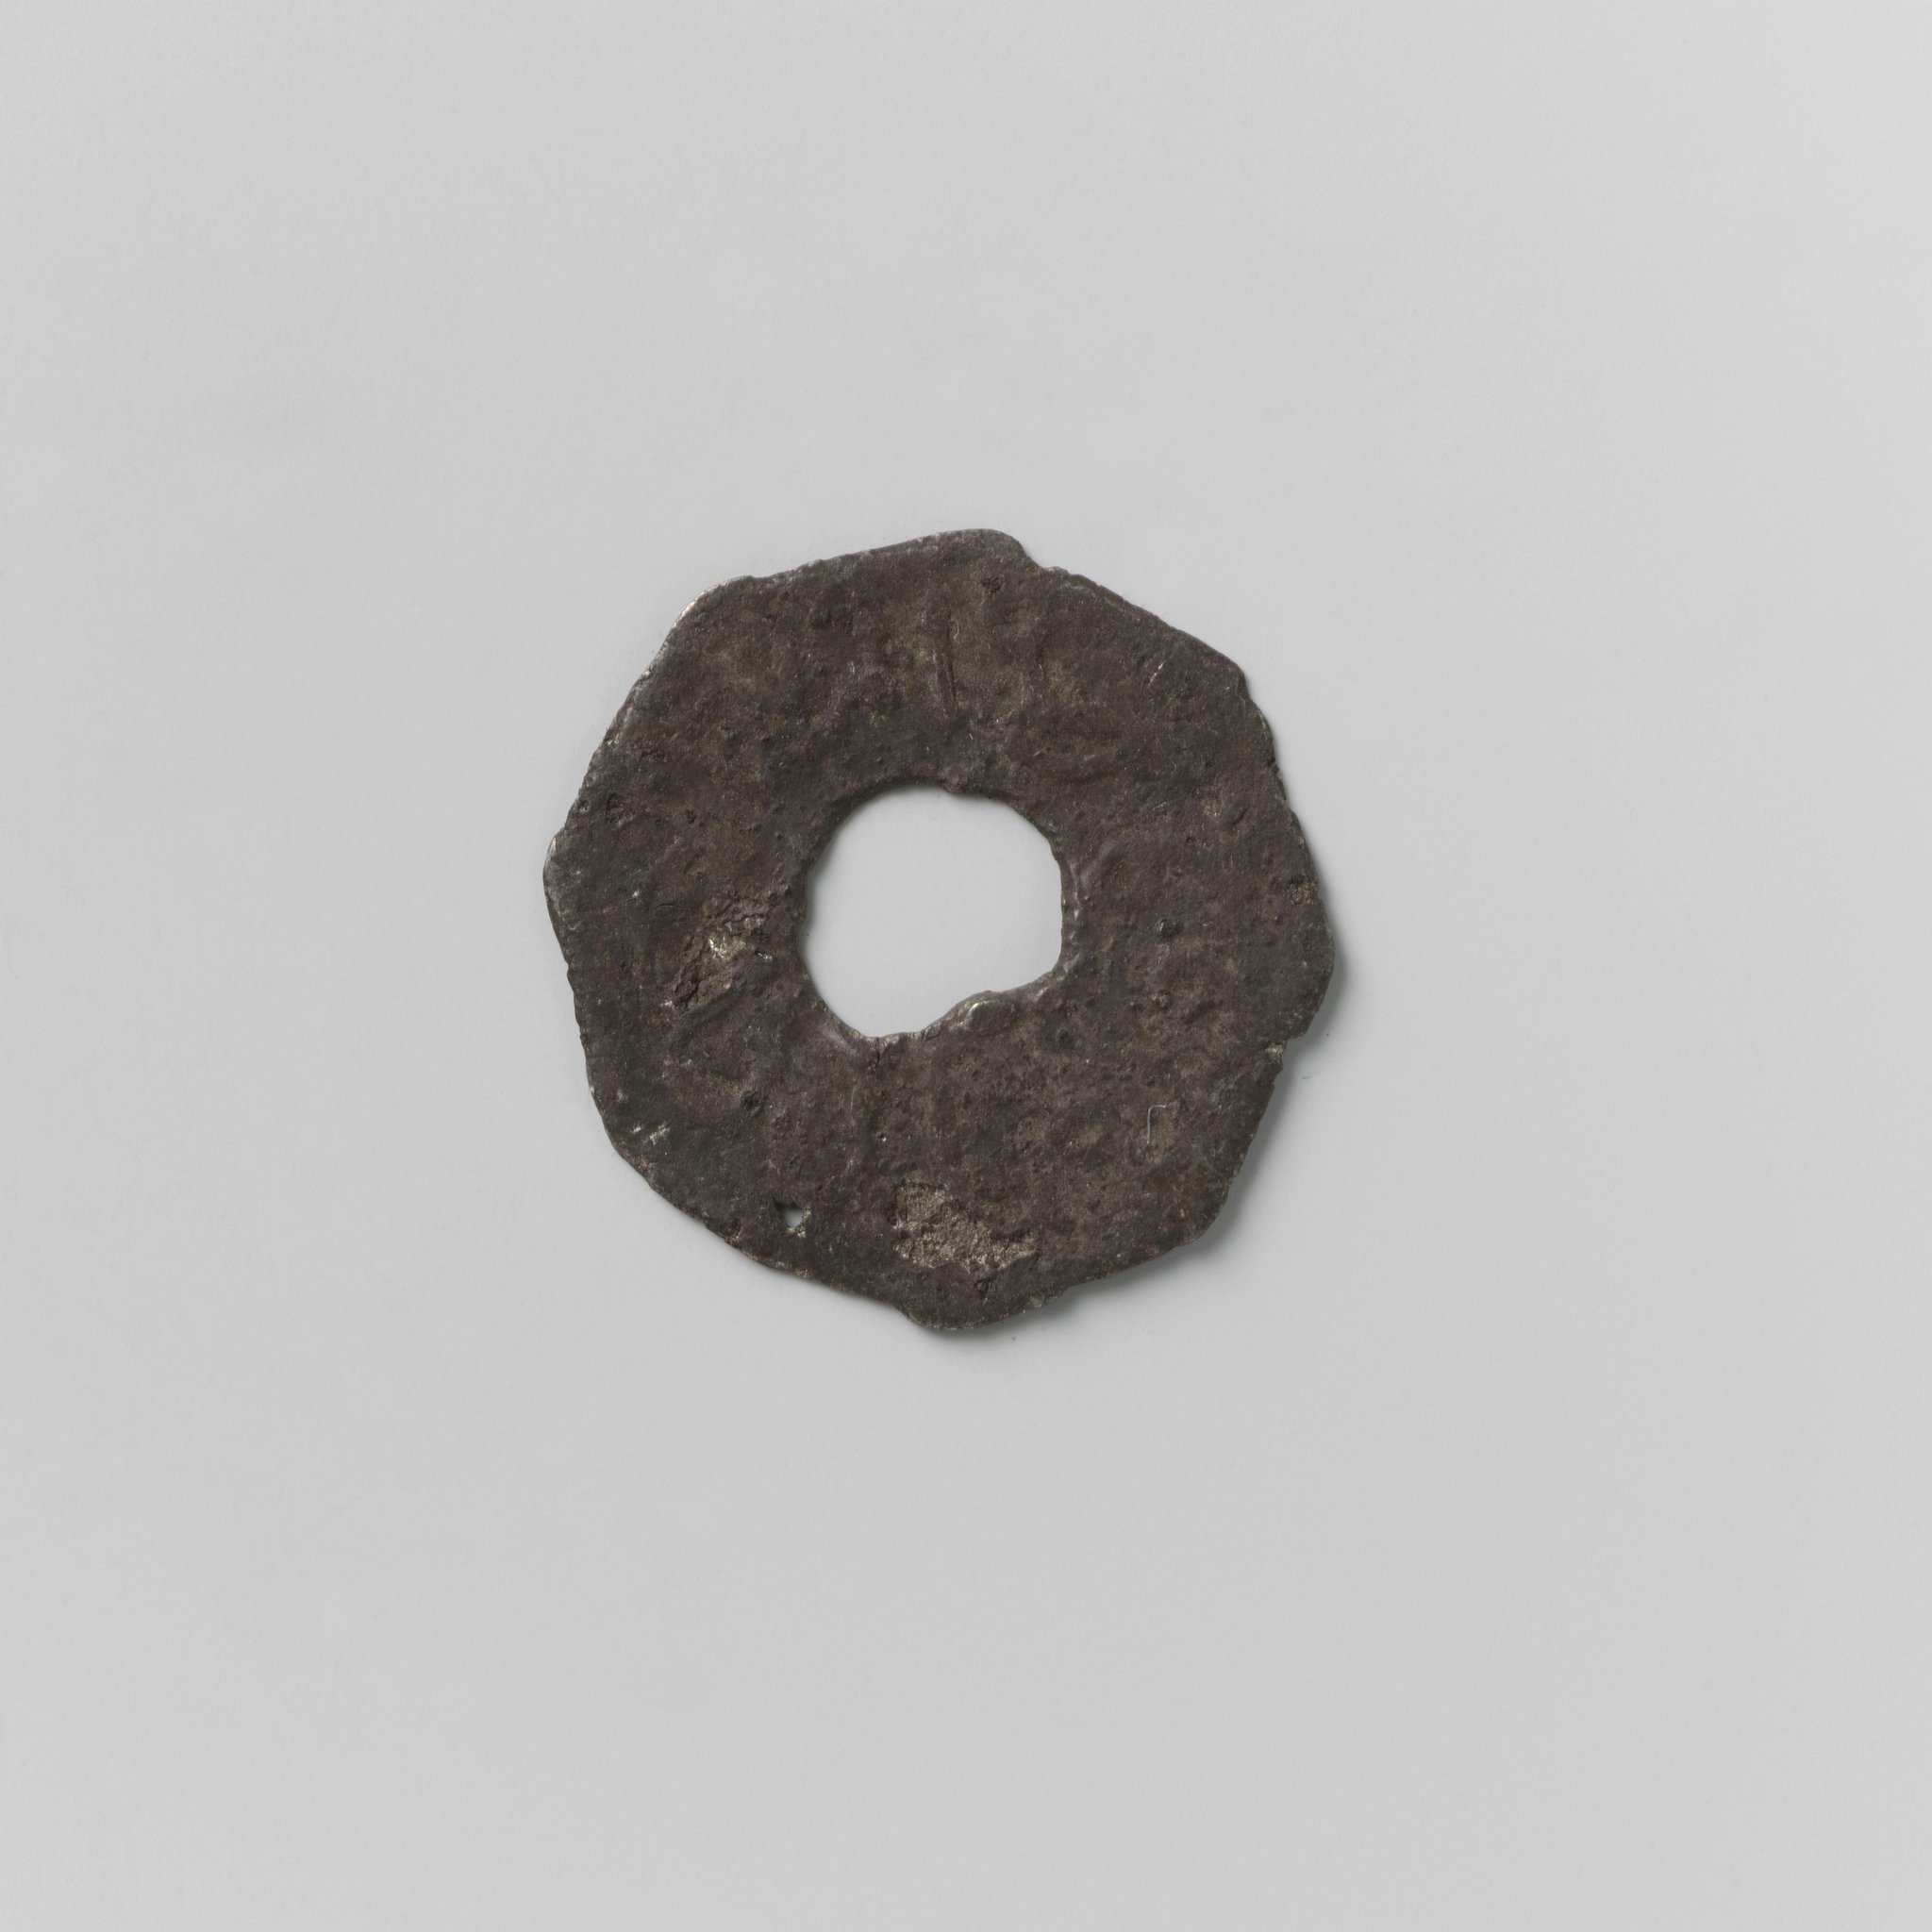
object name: coin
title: Palembang, Sumatra, sultan Mamoed Bader ed-din II, pitji, A.H. 1219 (1804)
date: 1804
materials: tin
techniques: casting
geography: palembang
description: Tinnen achthoekige munt. Voorzijde: omschrift in Arabische lettertekens, waartussen jaartal in Islamitische jaartelling. Keerzijde, glad. In het midden rond gat.